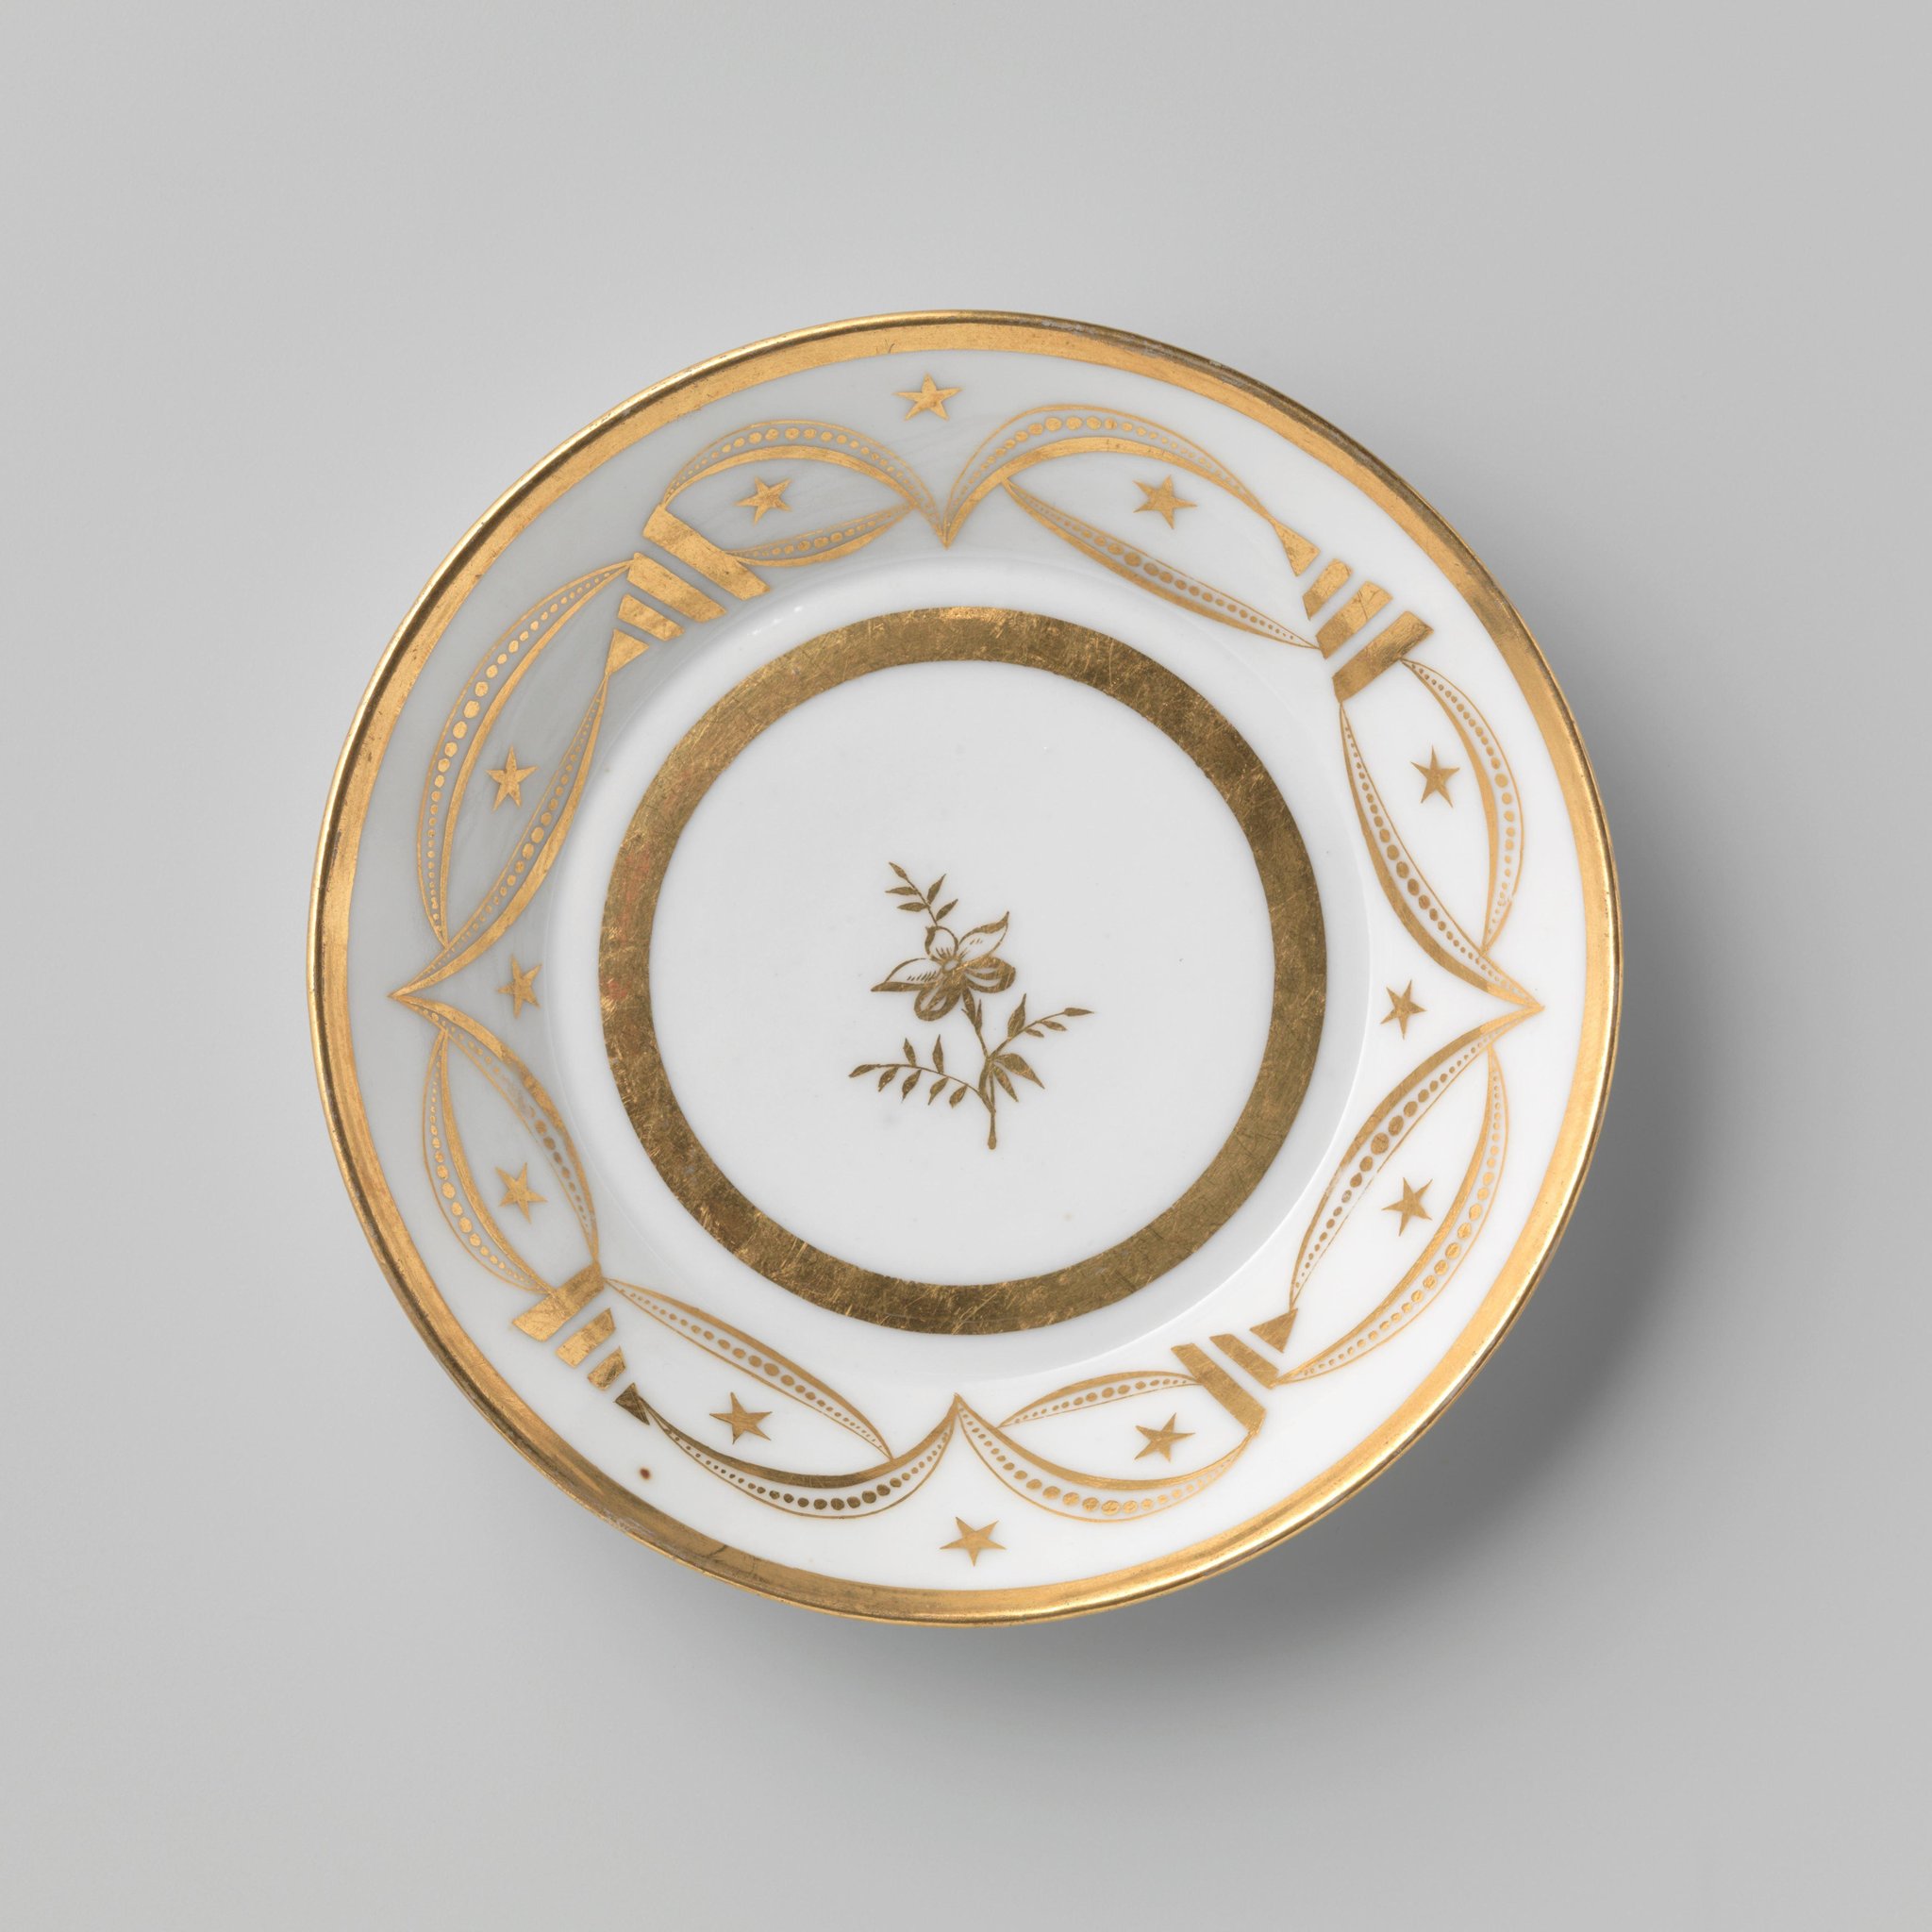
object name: platter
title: Saucer with an ornamental border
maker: Anonymous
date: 1800-1824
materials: glaze, gold, paint, porcelain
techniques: firing, forming, gilding, turning, vitrification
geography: france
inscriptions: mark: ‘g’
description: Schotel van porselein, versierd met gouden banden waartussen een slingermotief dat wordt gevormd door halvemaanvormige schijven waarin punten. De schijven worden verbonden door driehoeken. Op de tussenliggende velden gouden sterren. Op het plat een bloemtak. Behoort tot een serie van twaalf kop-en-schotels (BK-16044-F-1-24), onderdeel van een koffie- en theeservies.